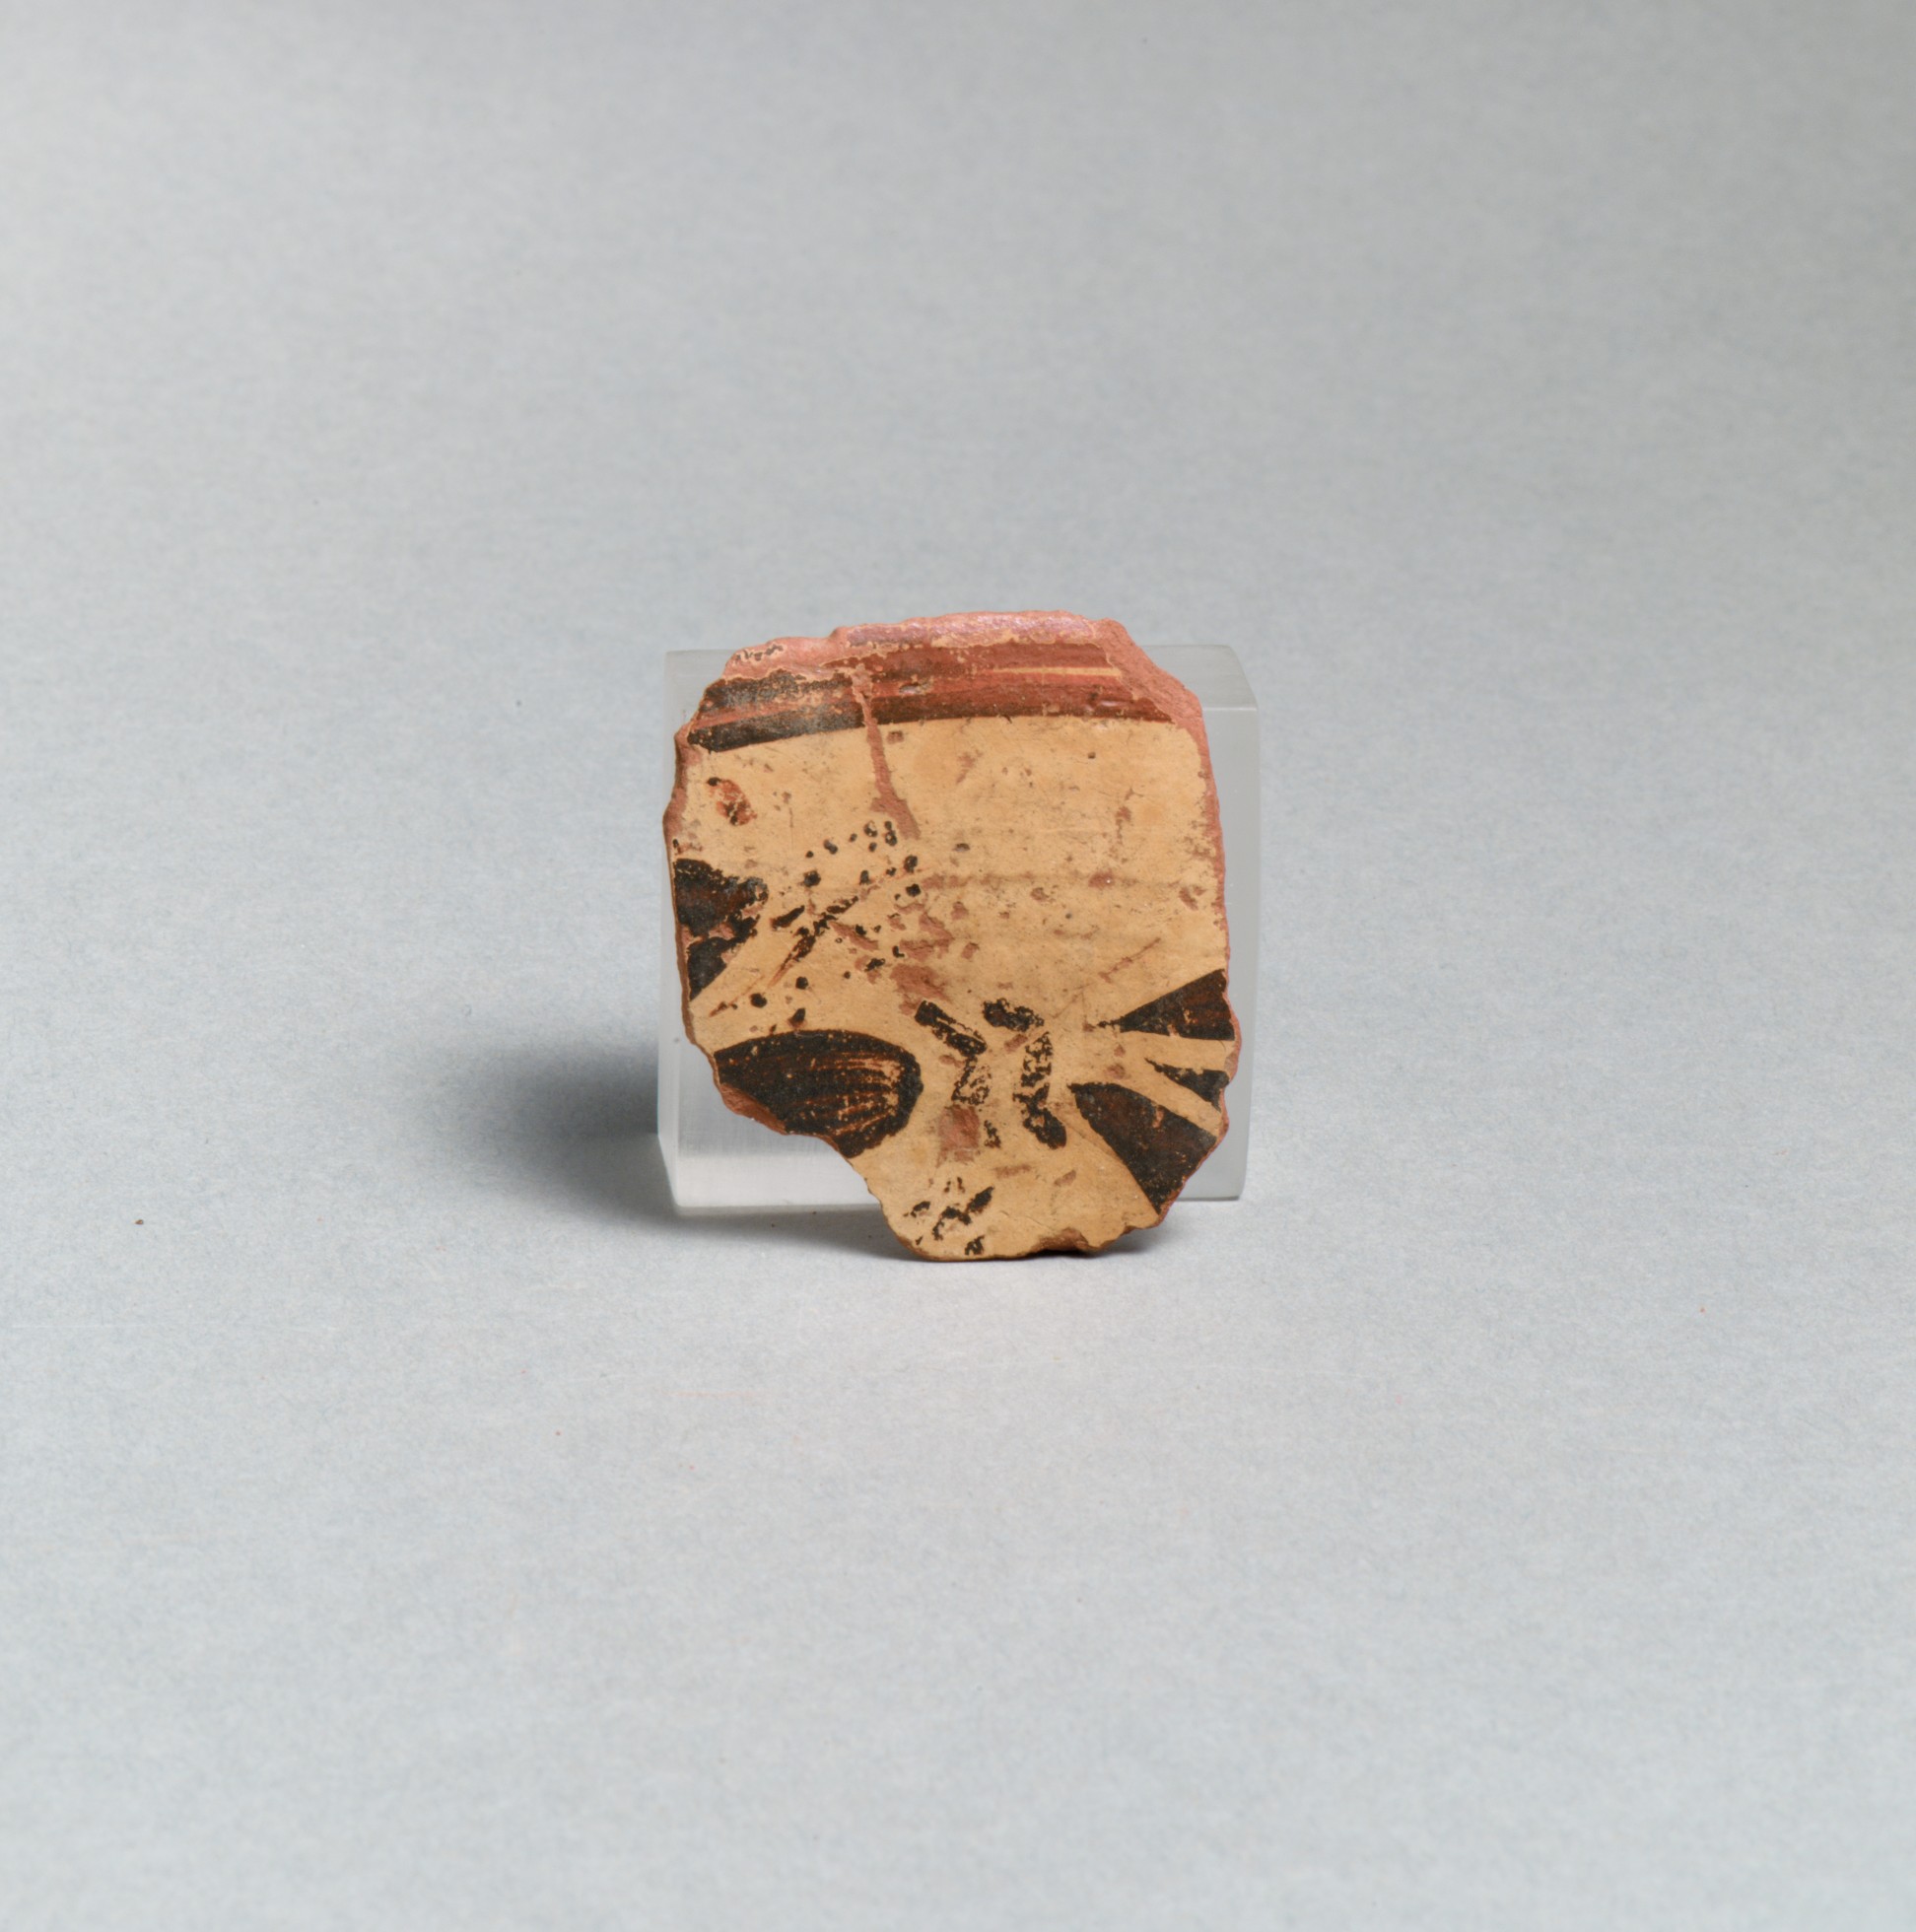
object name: lagynos fragment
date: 323 BCE-31 CE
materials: terracotta